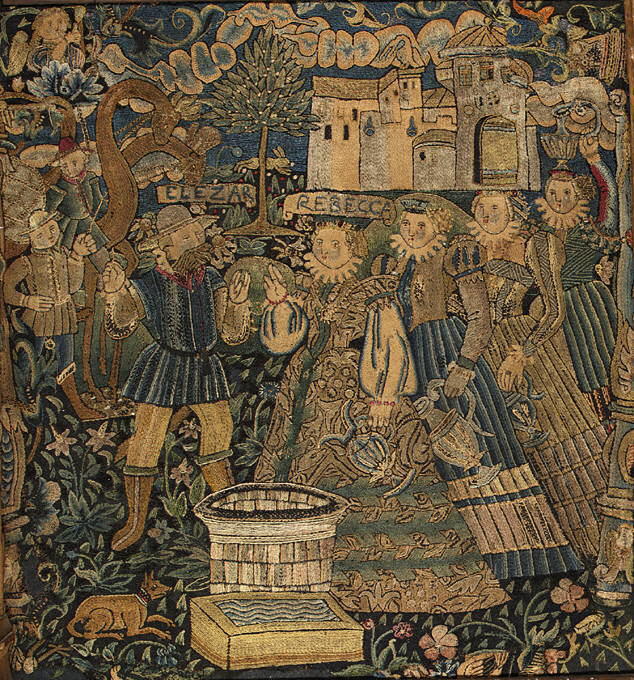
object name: panel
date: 1600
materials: metal thread, silk, wool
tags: men,women,dogs